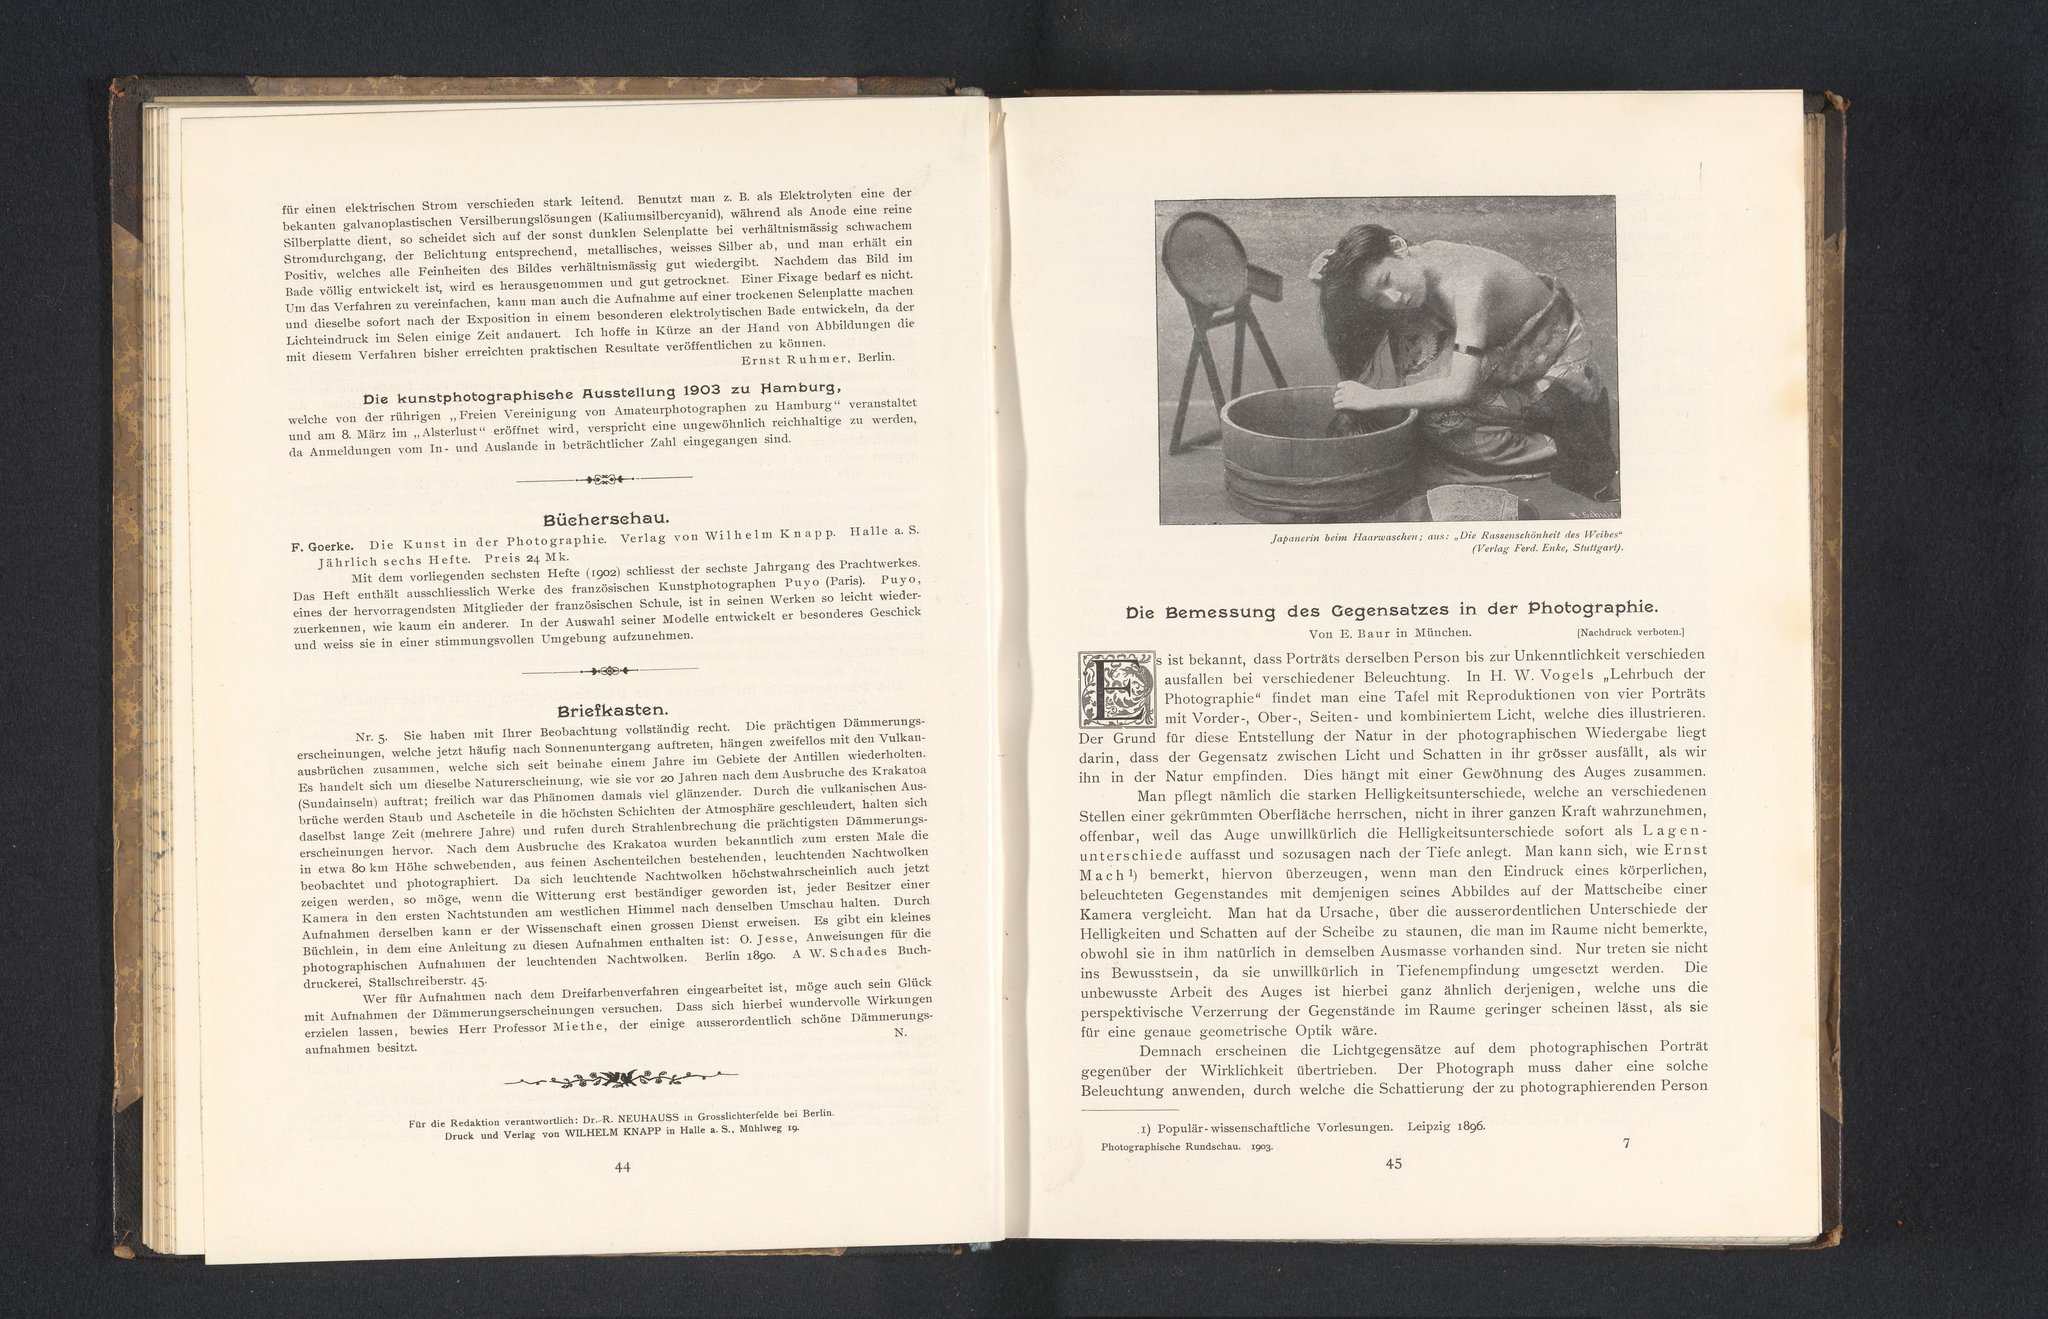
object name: page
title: Portret van een onbekende Japanse vrouw die haar haren wast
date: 1898-1903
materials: paper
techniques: autotype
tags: historical persons not known by name - bb - woman, japanese, washing one's face and head